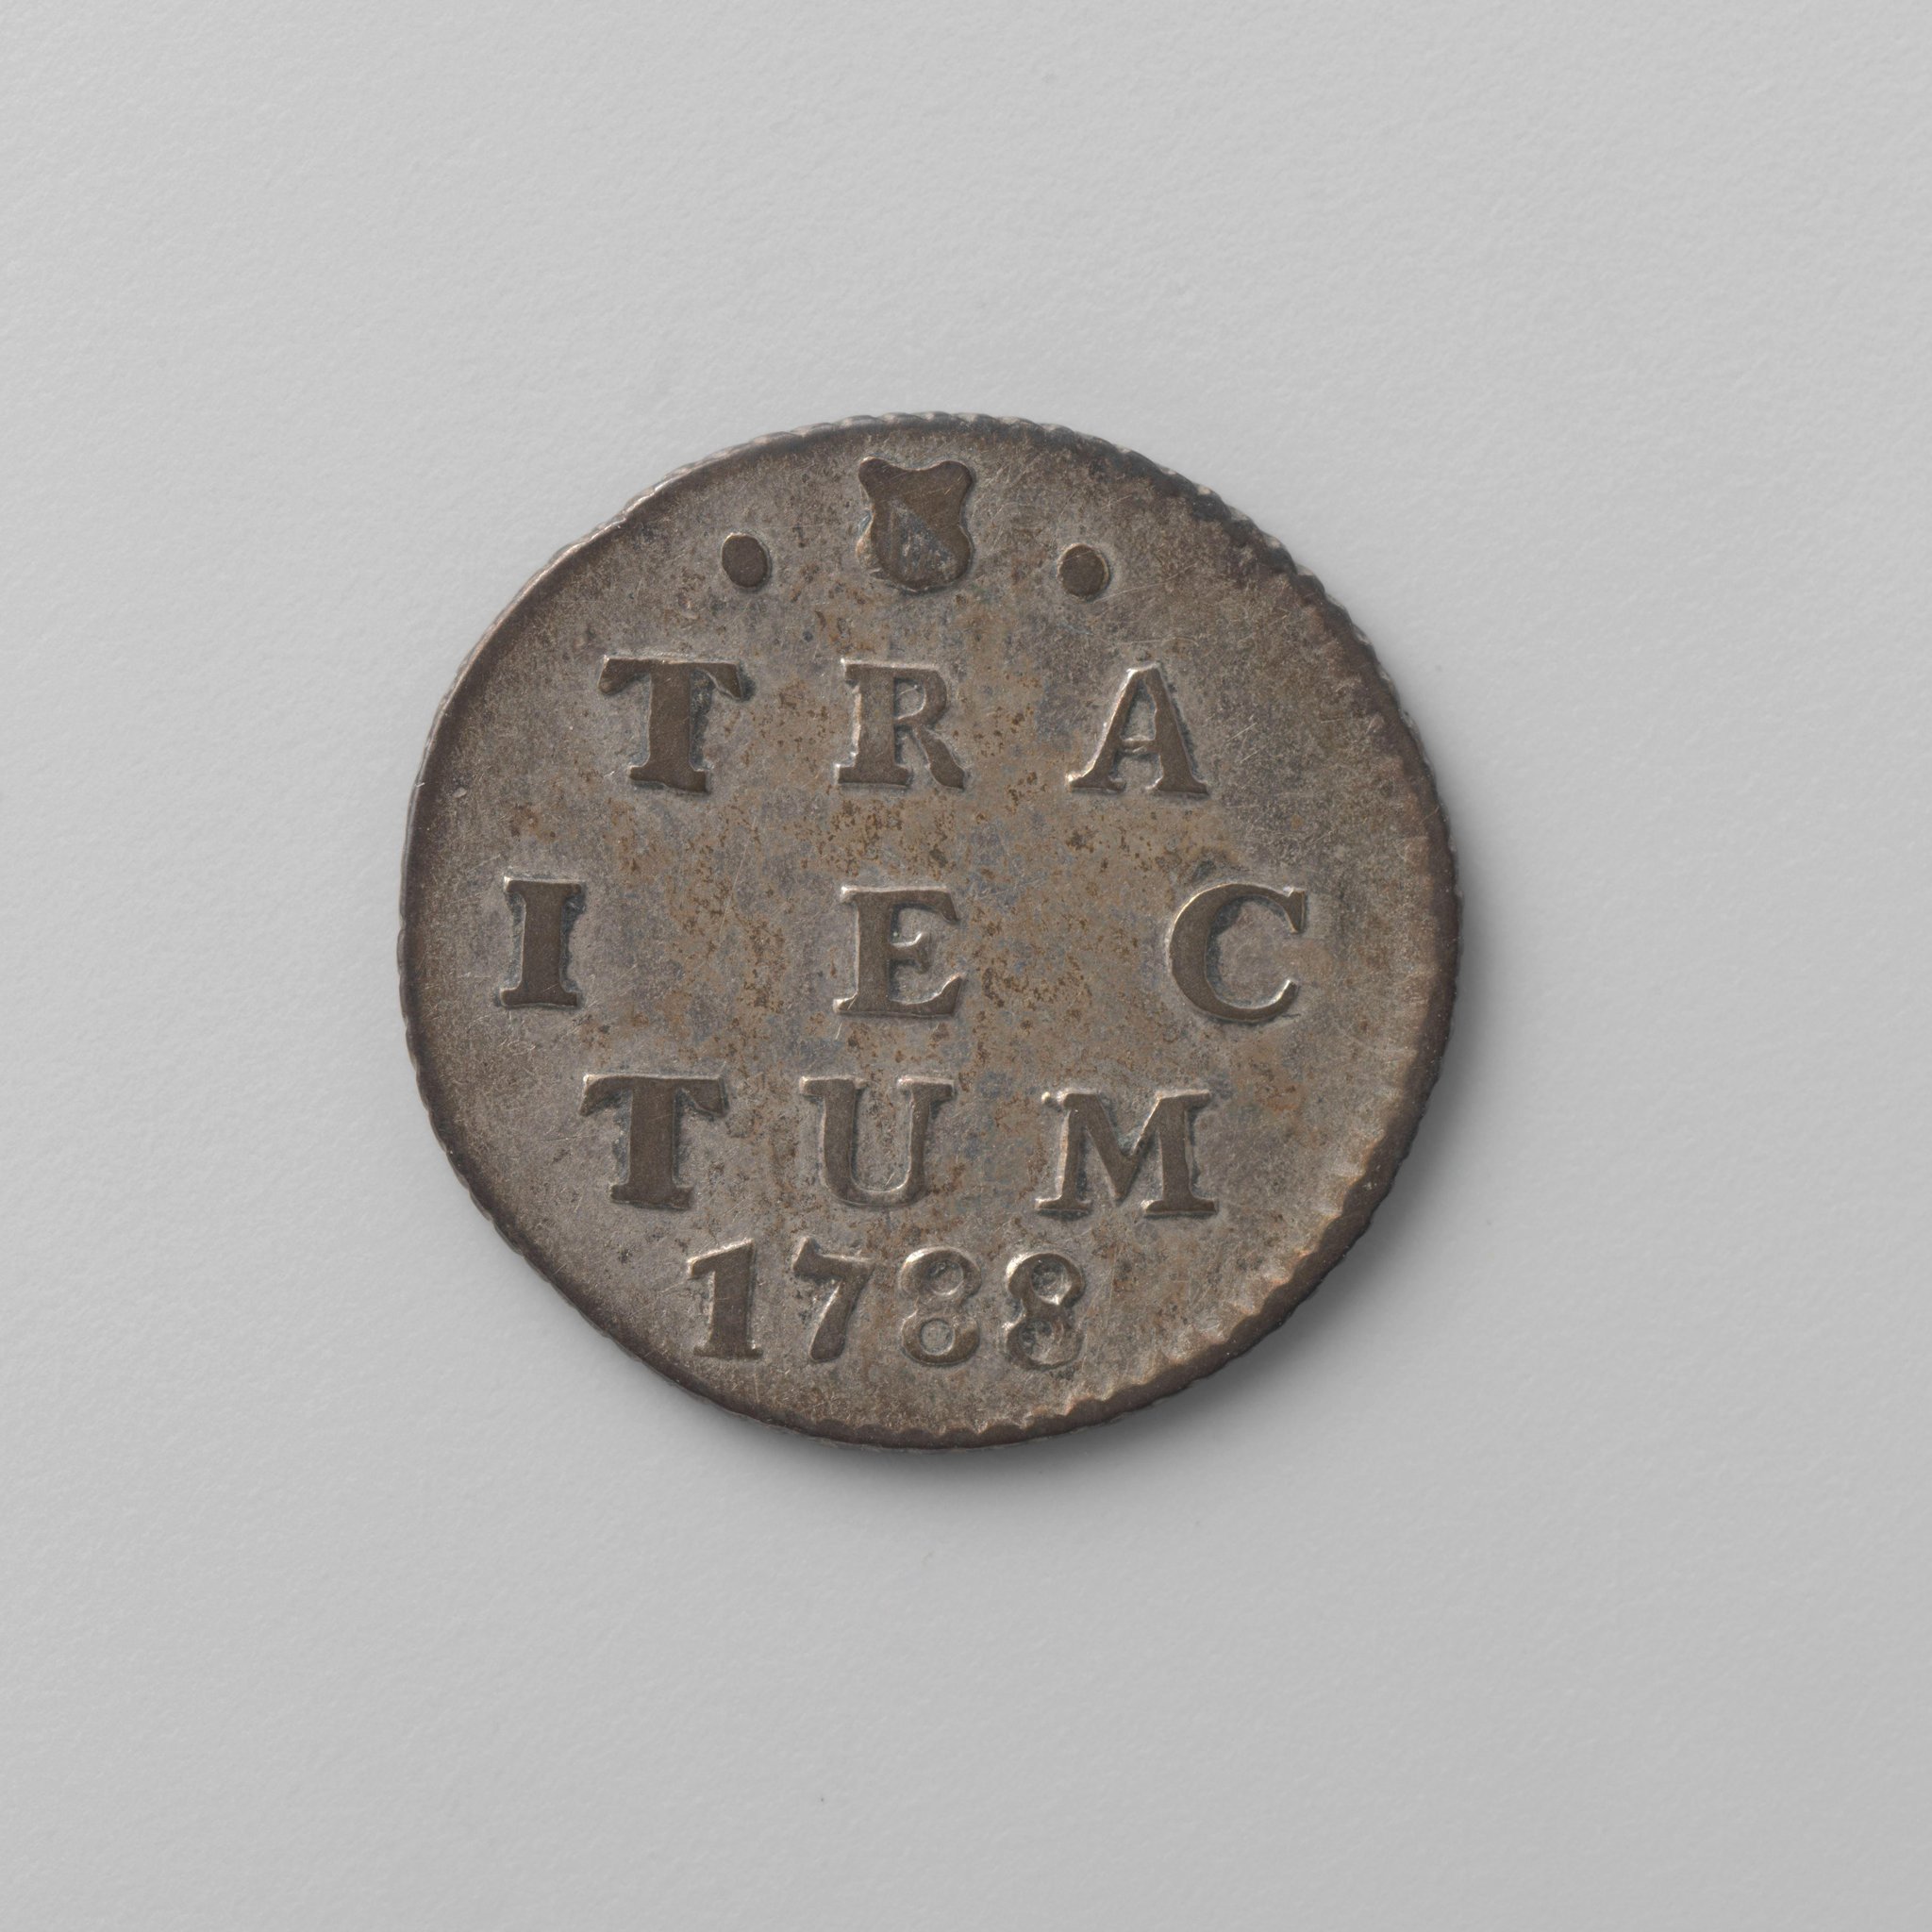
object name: coin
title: Utrecht, dubbele stuiver, 1788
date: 1788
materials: silver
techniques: striking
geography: utrecht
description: Zilveren munt. Voorzijde: tussen waarde-aanduiding 2 S gekroond enkelveldig wapenschild van Utrecht. Keerzijde: onder muntteken tussen twee puntjes opschrift: provincienaam in drie regels, daaronder jaartal. Kabelrand.